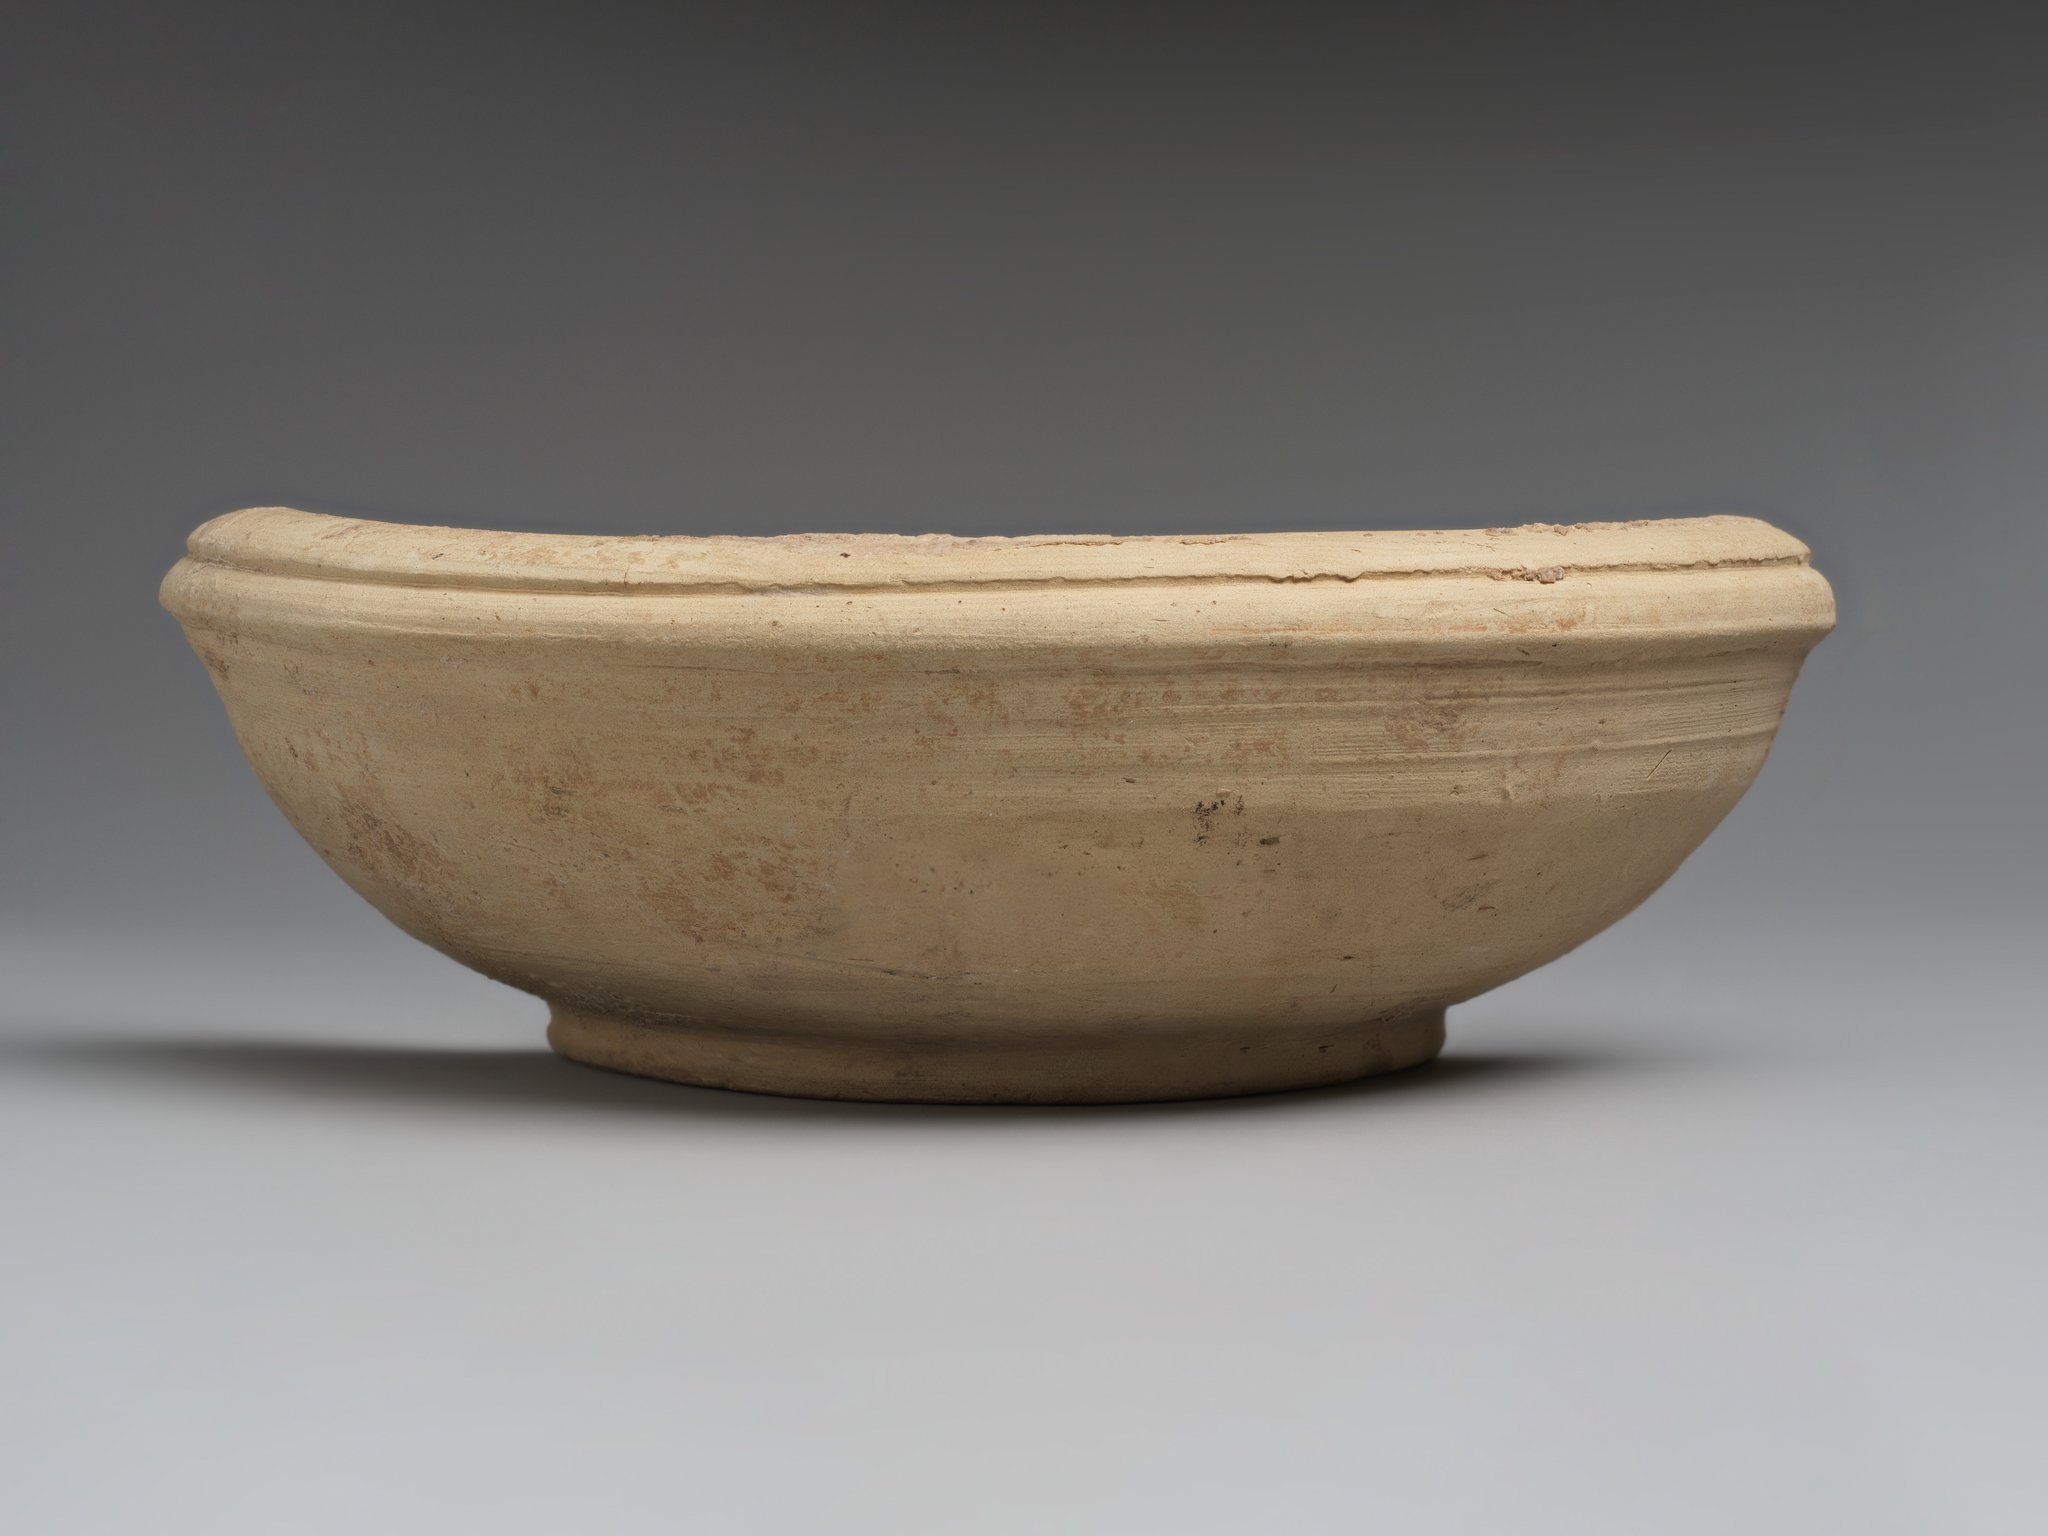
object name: bowl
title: Bowl sherd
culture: assyrian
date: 800-601 BCE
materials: ceramic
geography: mesopotamia